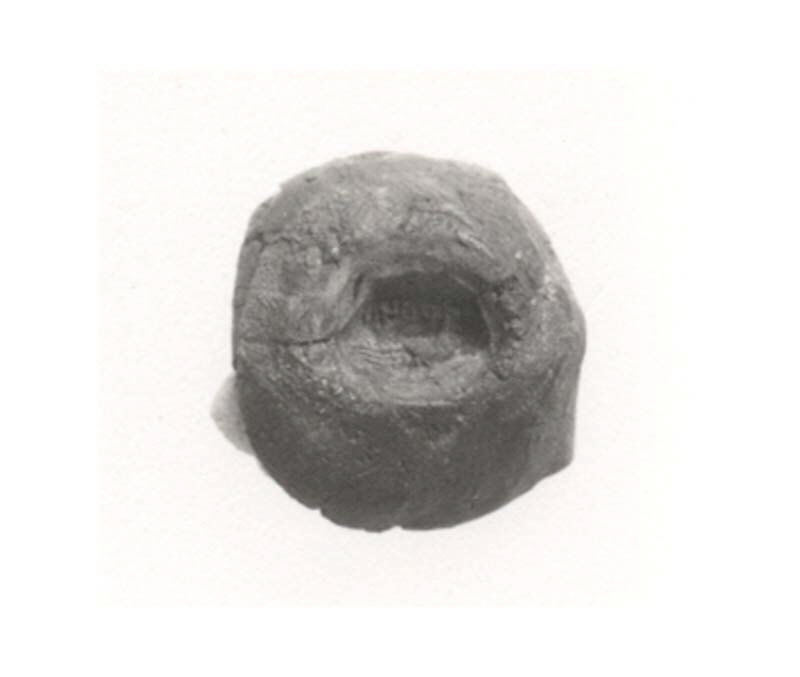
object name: sealing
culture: sasanian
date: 601-700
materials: clay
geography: iran